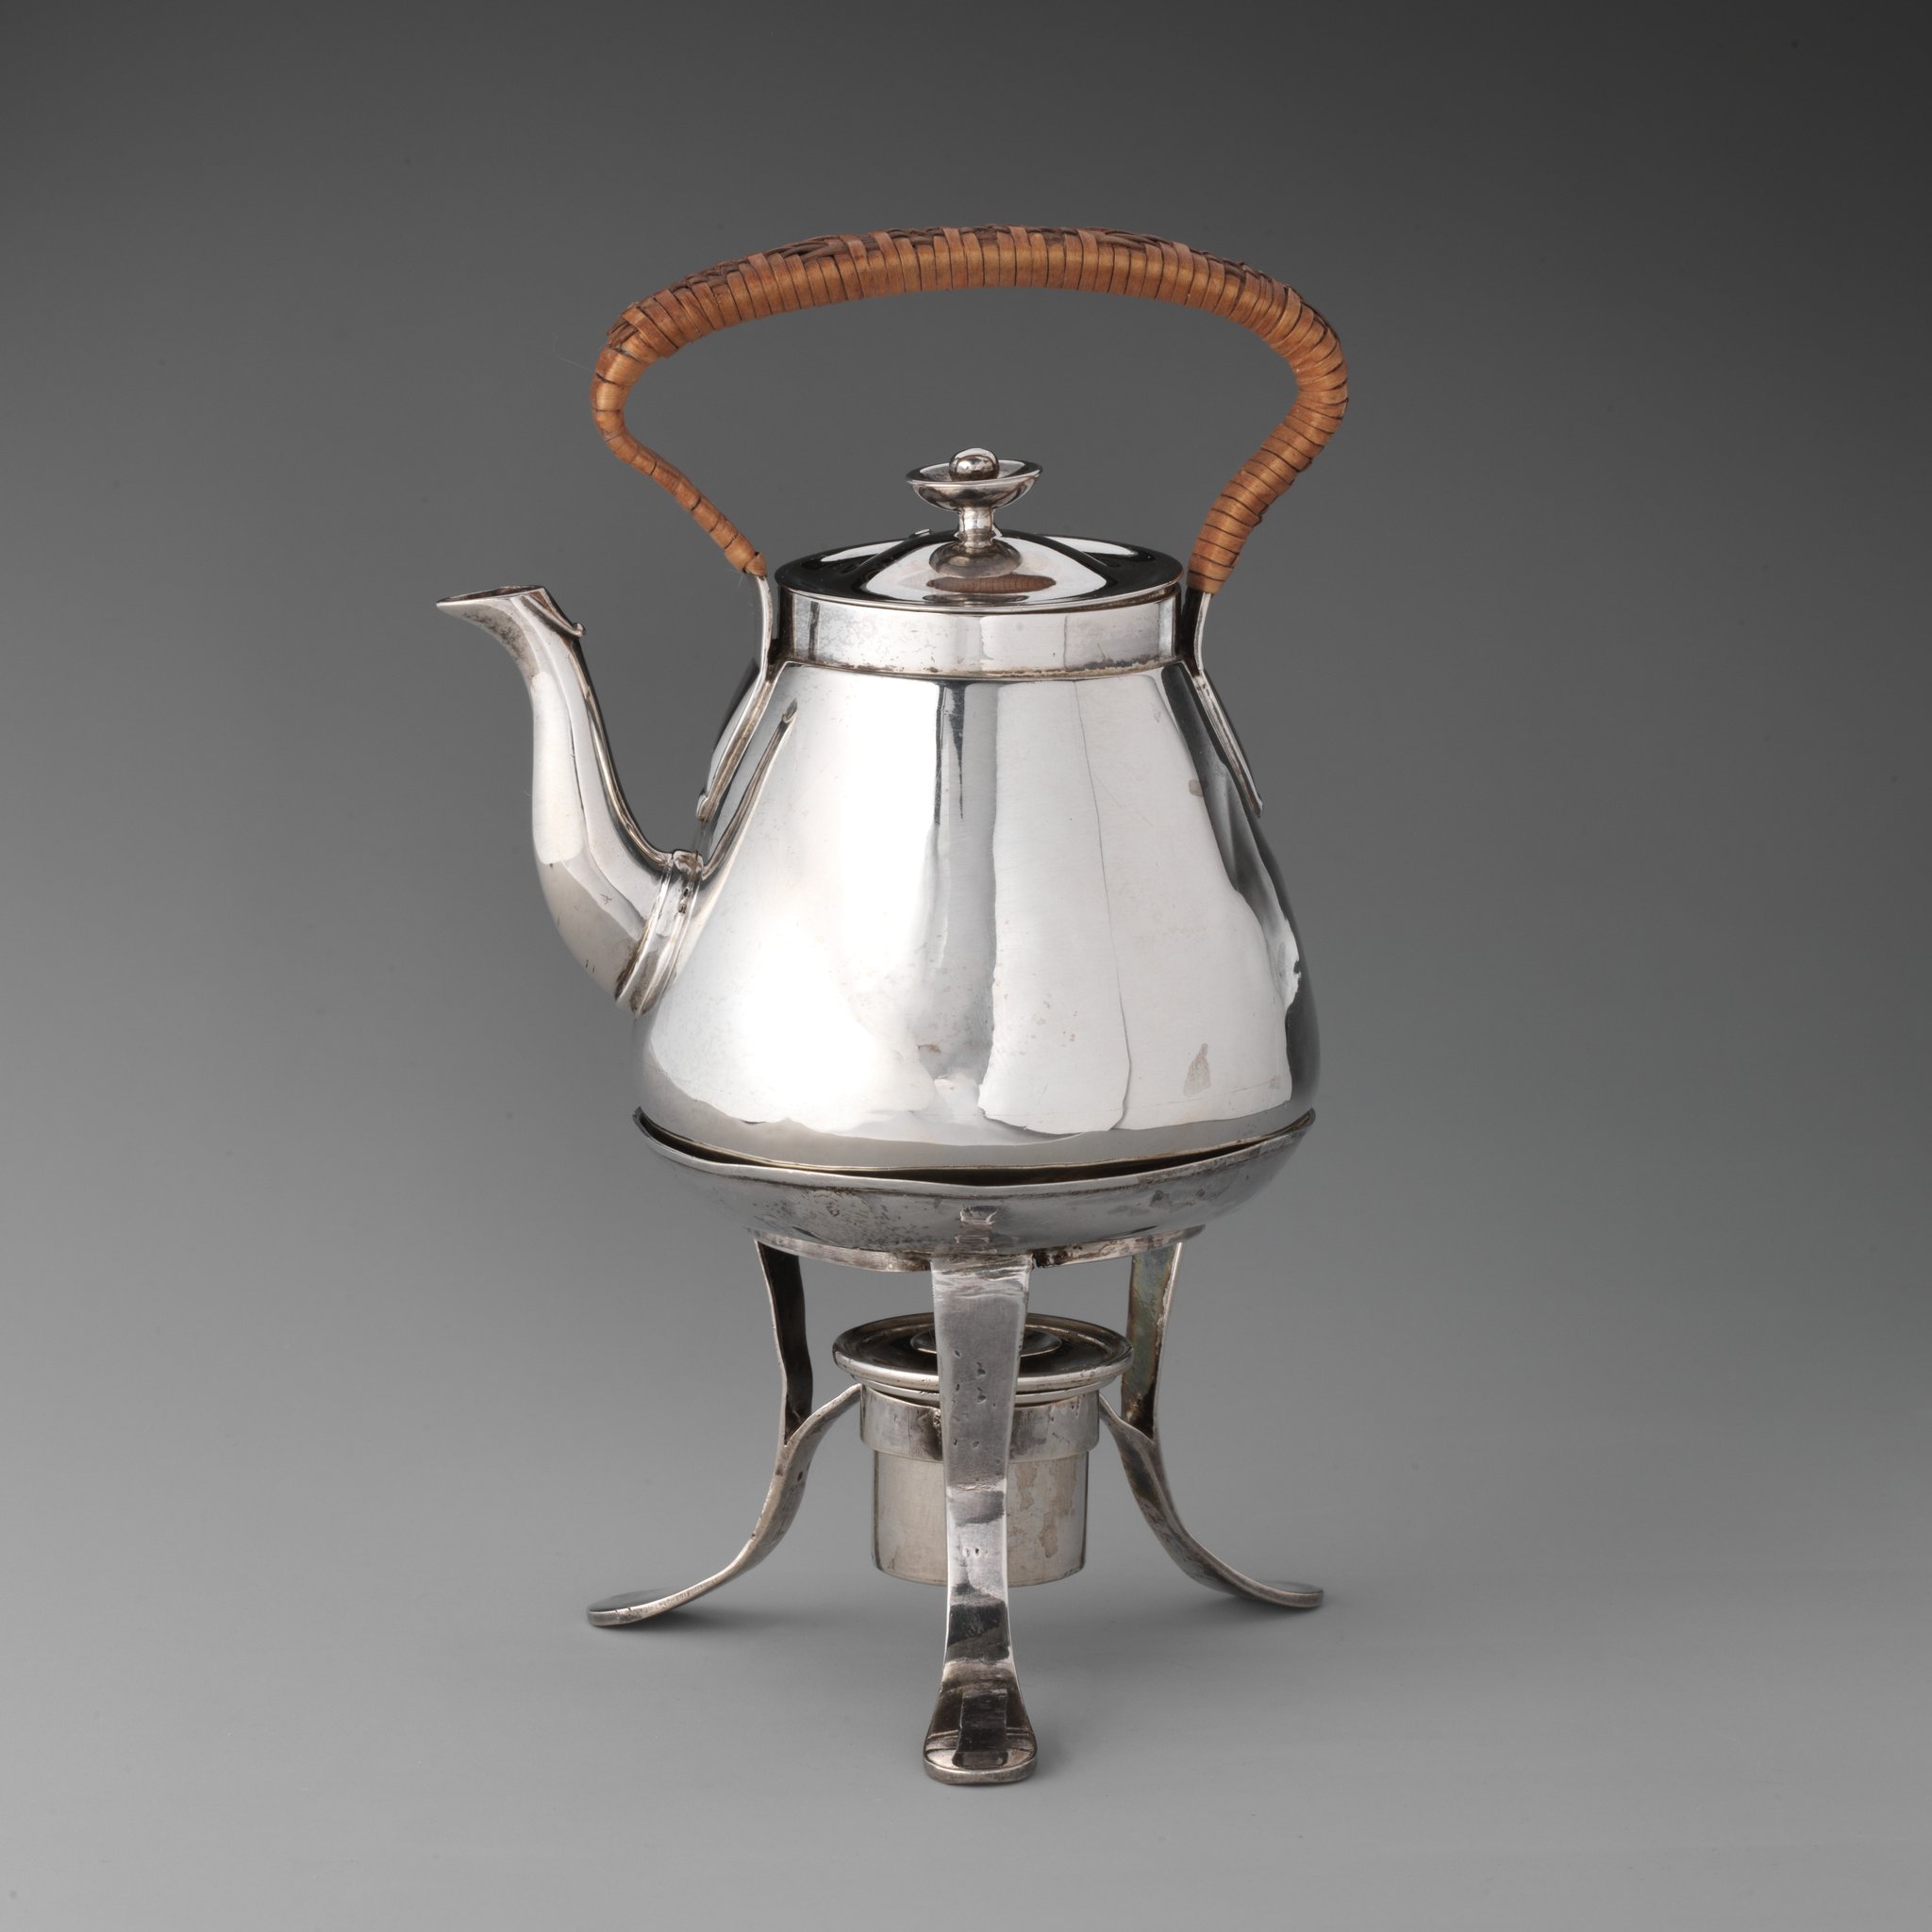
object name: kettle with stand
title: Miniature kettle with stand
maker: w. h.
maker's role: maker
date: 1795-1796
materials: silver